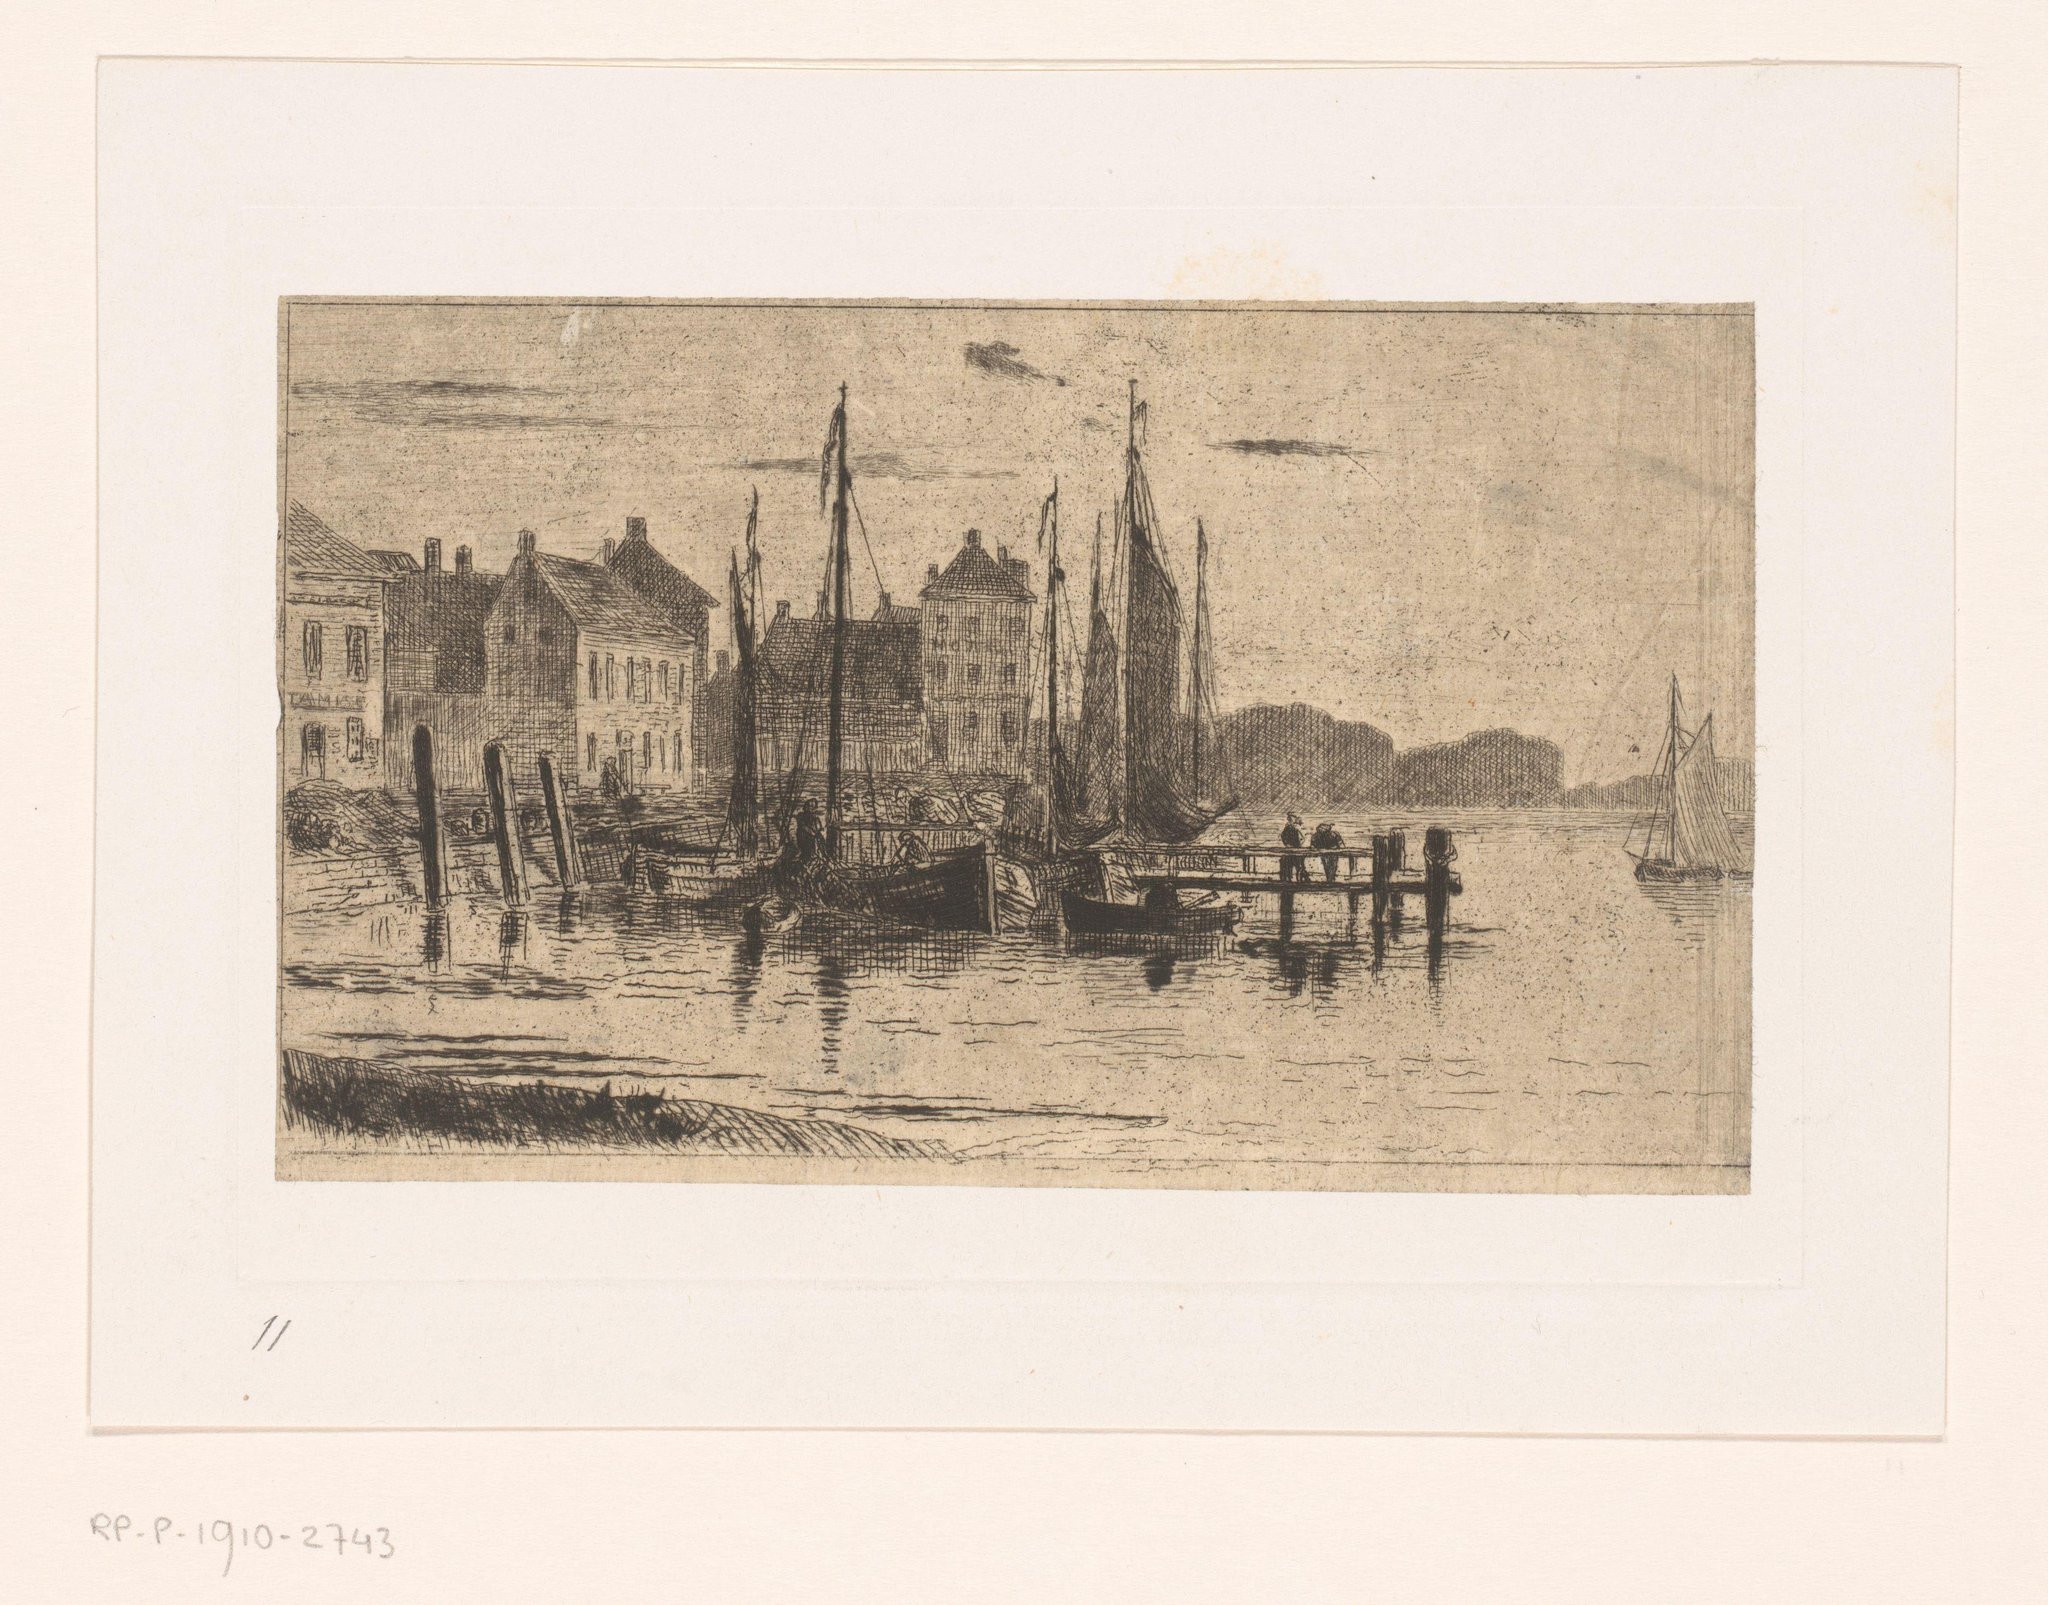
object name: print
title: Haven in Temse aan de Schelde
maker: carel nicolaas storm van s-gravesande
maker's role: draughtsman, print maker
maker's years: 1841-1924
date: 1851-1910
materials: paper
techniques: etching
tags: harbour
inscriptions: collector's mark: Lugt 2228, inscription: ‘tamise sur l'escaut’